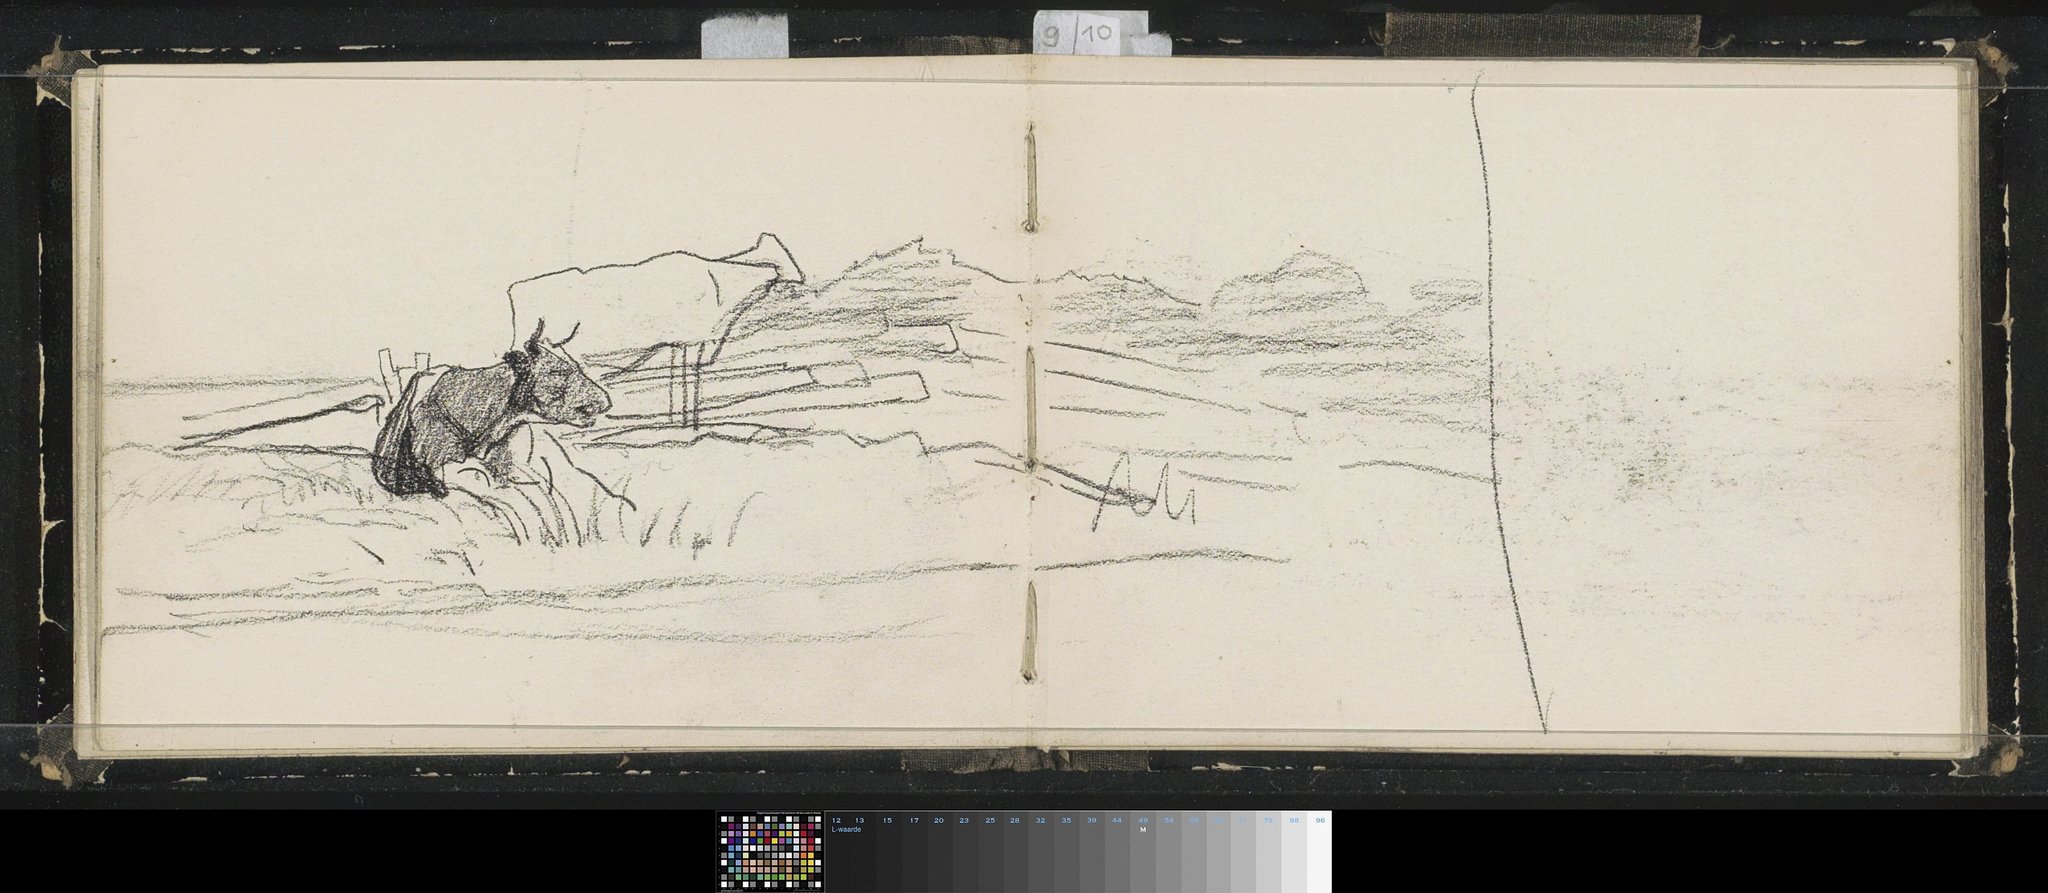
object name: sketchbook leaf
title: Liggende en staande koe in een weiland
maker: anton mauve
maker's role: draughtsman, painter, print maker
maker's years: 1838-1888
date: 1848-1888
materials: chalk, paper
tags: cow, meadow, pasture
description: Blad 8 verso en 9 recto uit een schetsboek met 33 bladen.